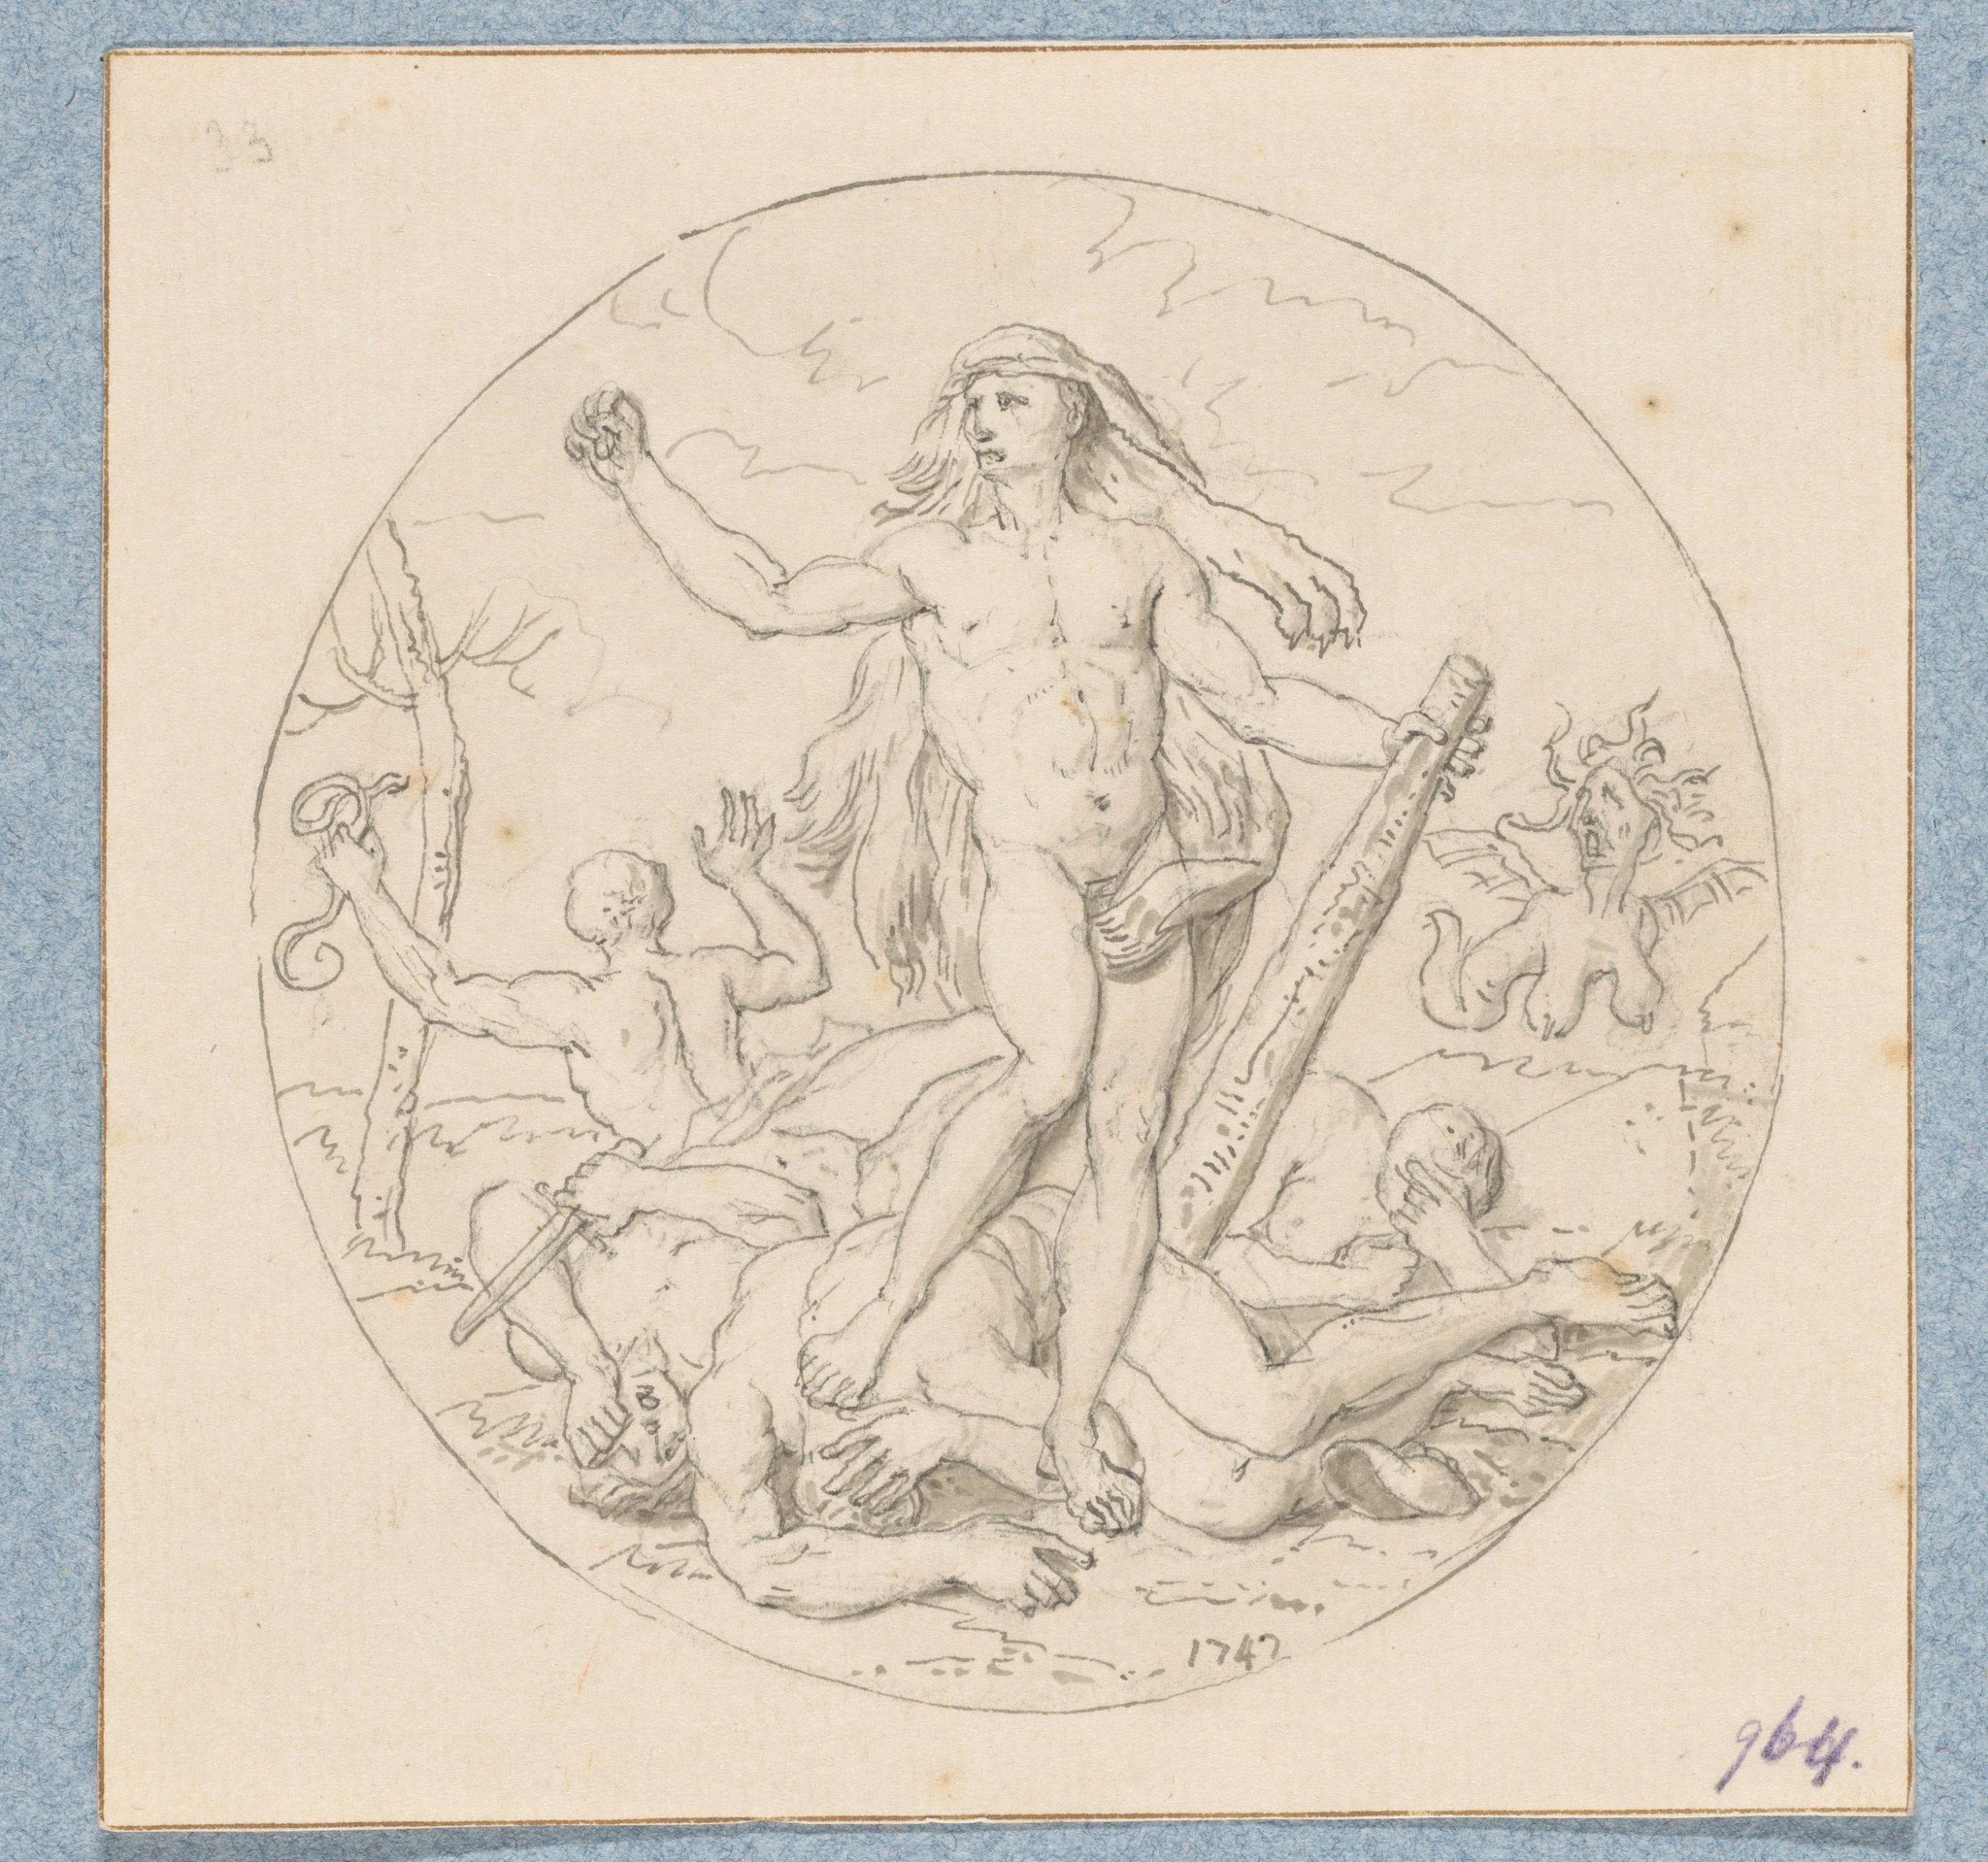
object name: drawing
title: Hercules als overwinnaar (in doos met 43 tekeningen)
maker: louis fabritius dubourg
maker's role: draughtsman, print maker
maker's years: 1693-1775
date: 1747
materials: ink, paper, pencil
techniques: brush, pen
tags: (story of) hercules (heracles)